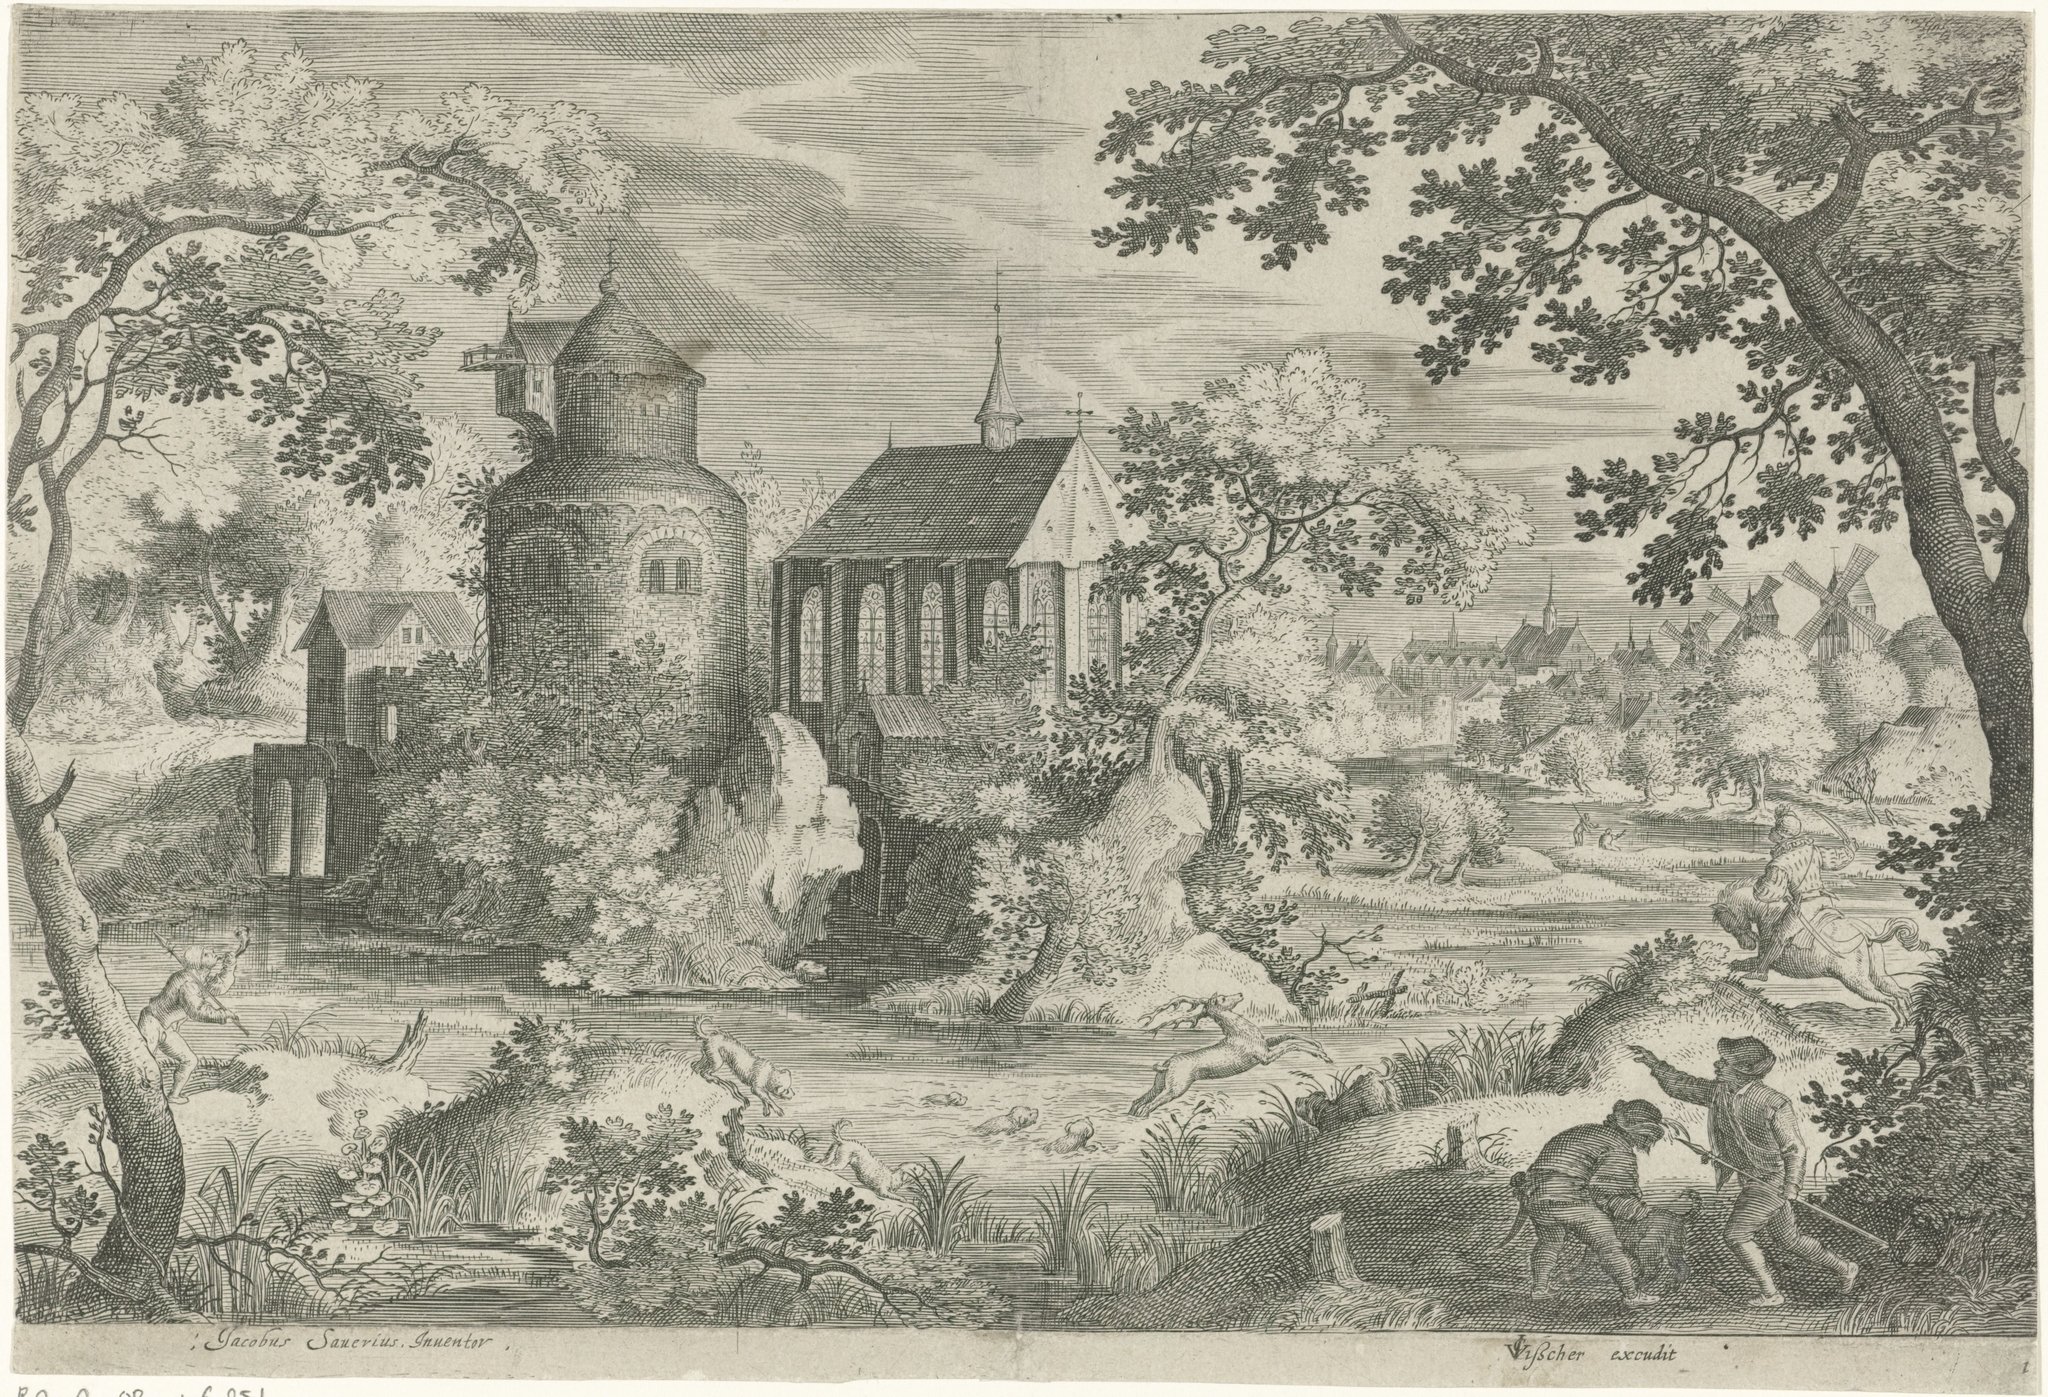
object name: print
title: Hertenjacht bij een kapel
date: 1602-1652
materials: paper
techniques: engraving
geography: amsterdam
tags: swamp, inland marsh, fens, stag-hunting, church (exterior) - qq - small church, chapel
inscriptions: collector's mark: Lugt 2228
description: In een bosrijk moeras in de nabijheid van een dorp en een kapel jaagt een aantal mannen met hun honden op een hert. Prent rechtsonder genummerd: 1.